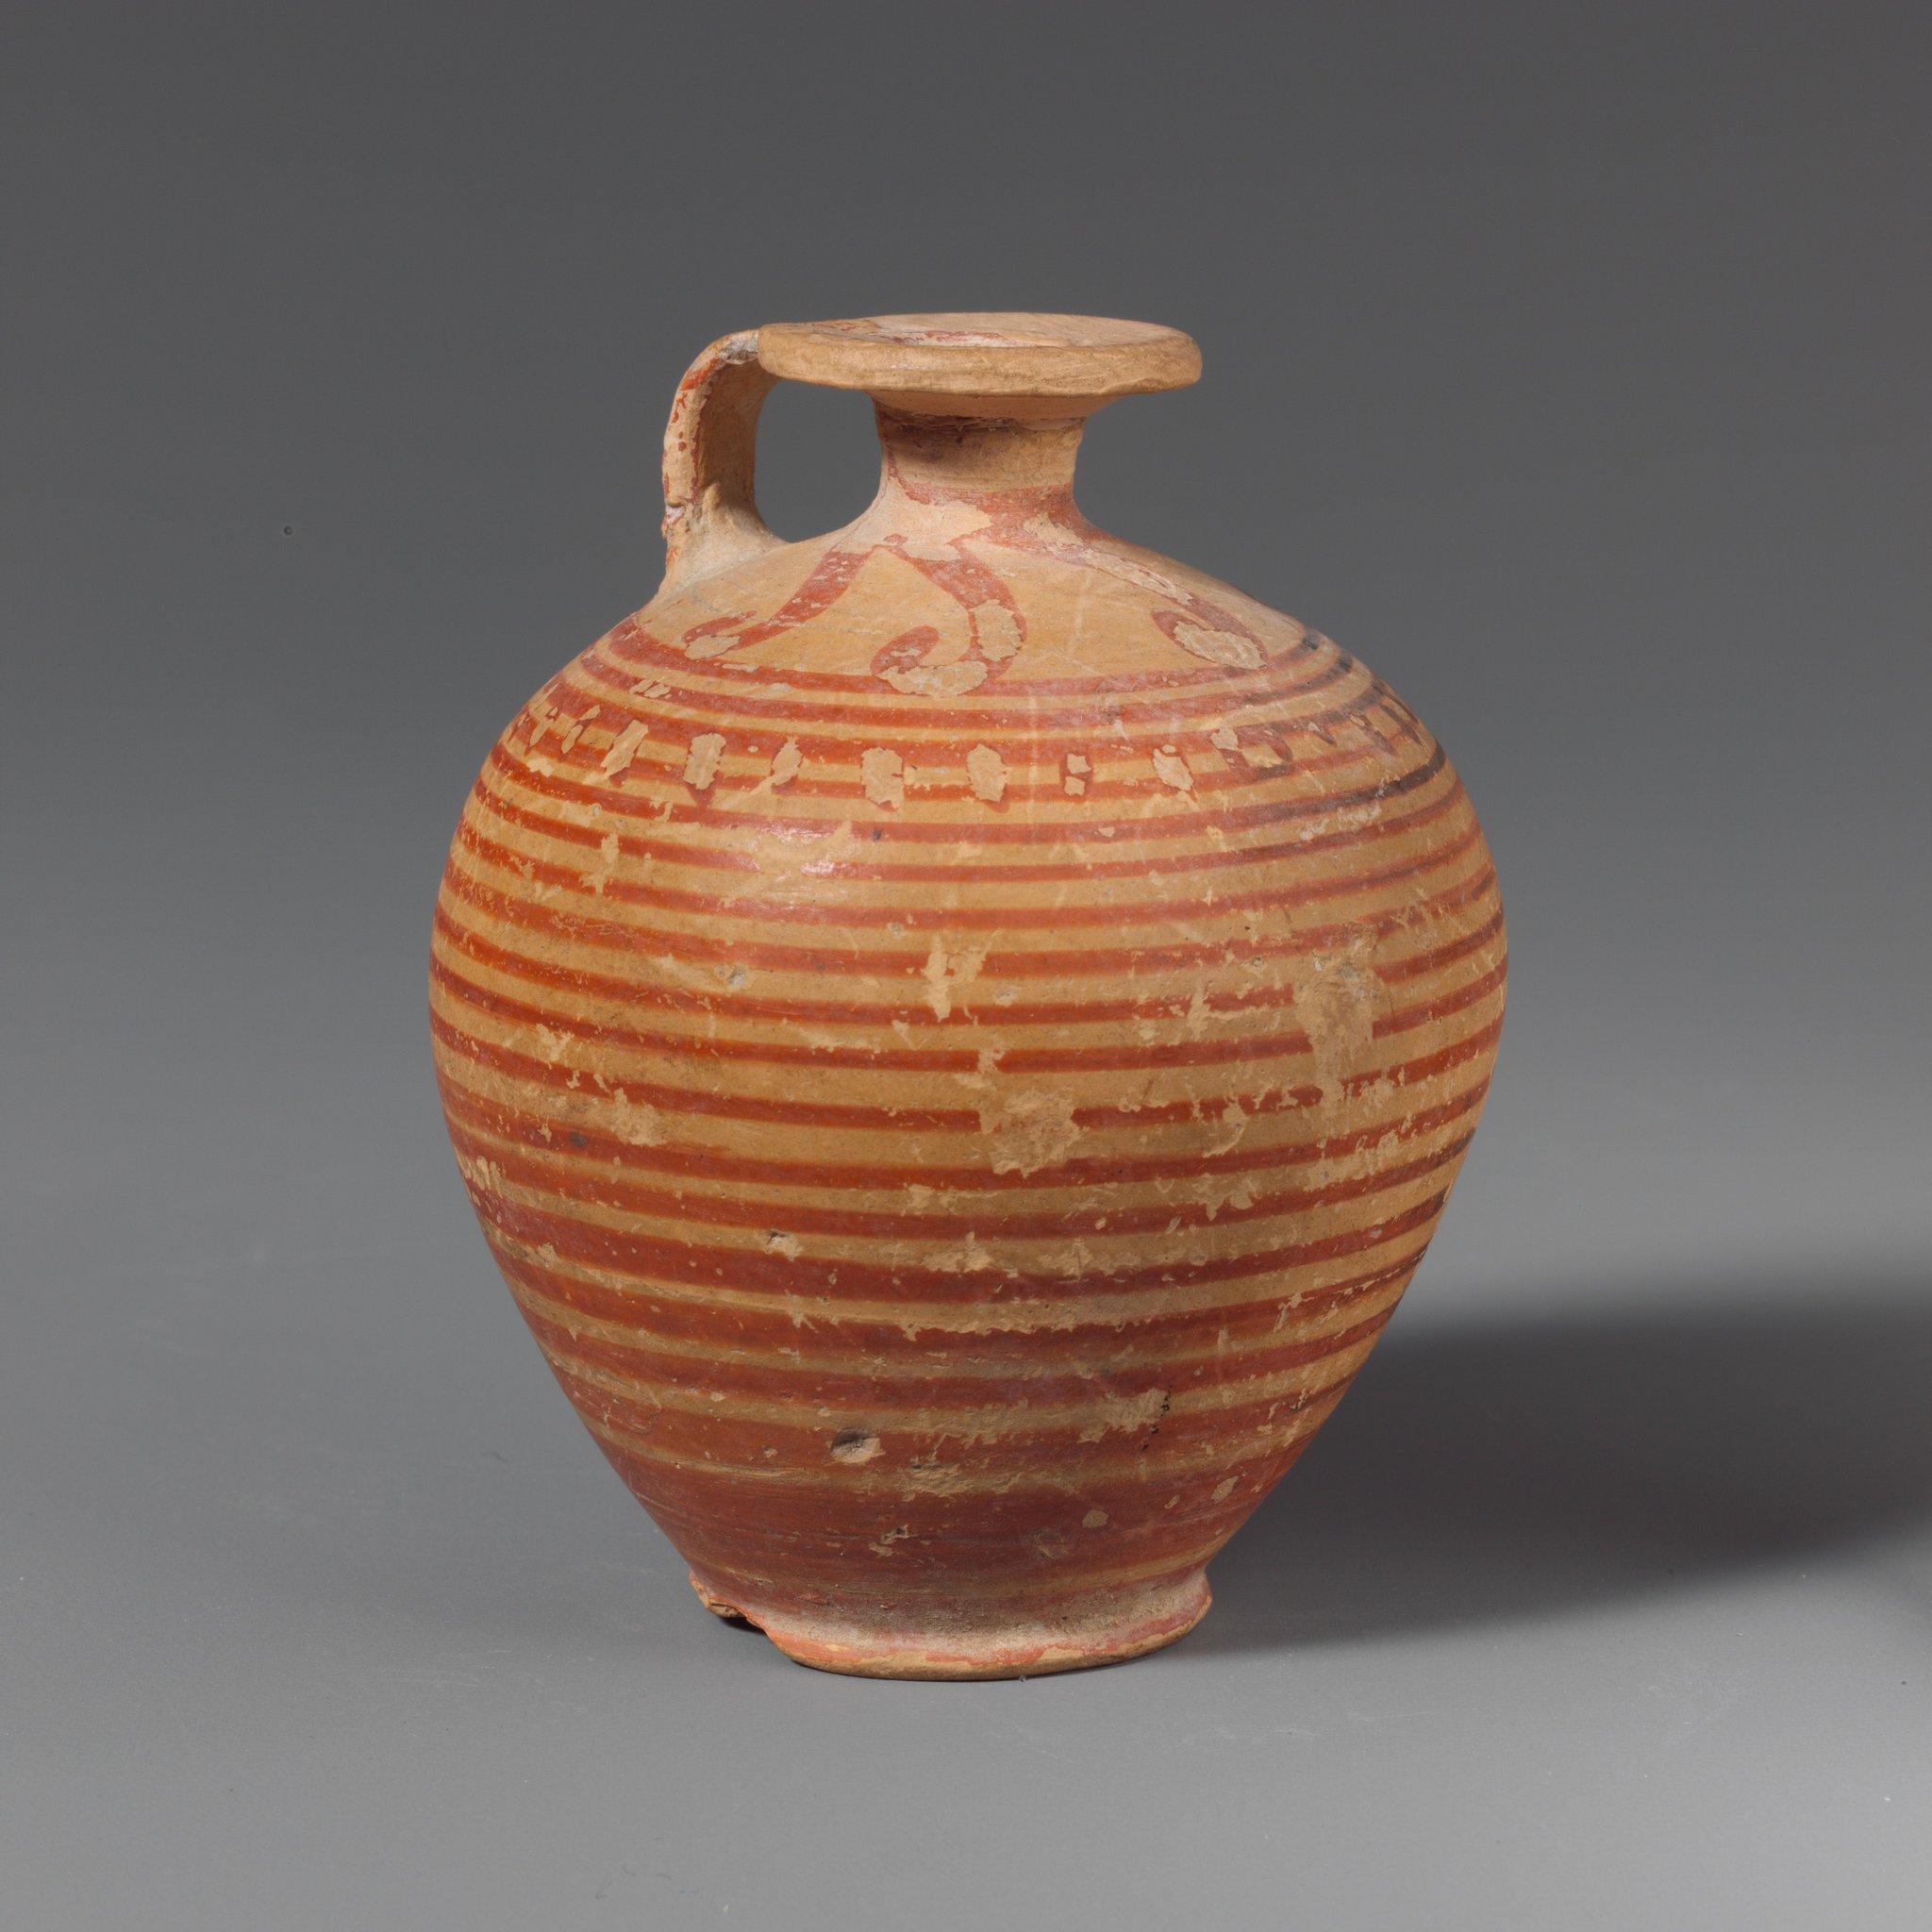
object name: aryballos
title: Terracotta aryballos (oil flask)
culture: greek, corinthian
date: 734-668 BCE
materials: terracotta